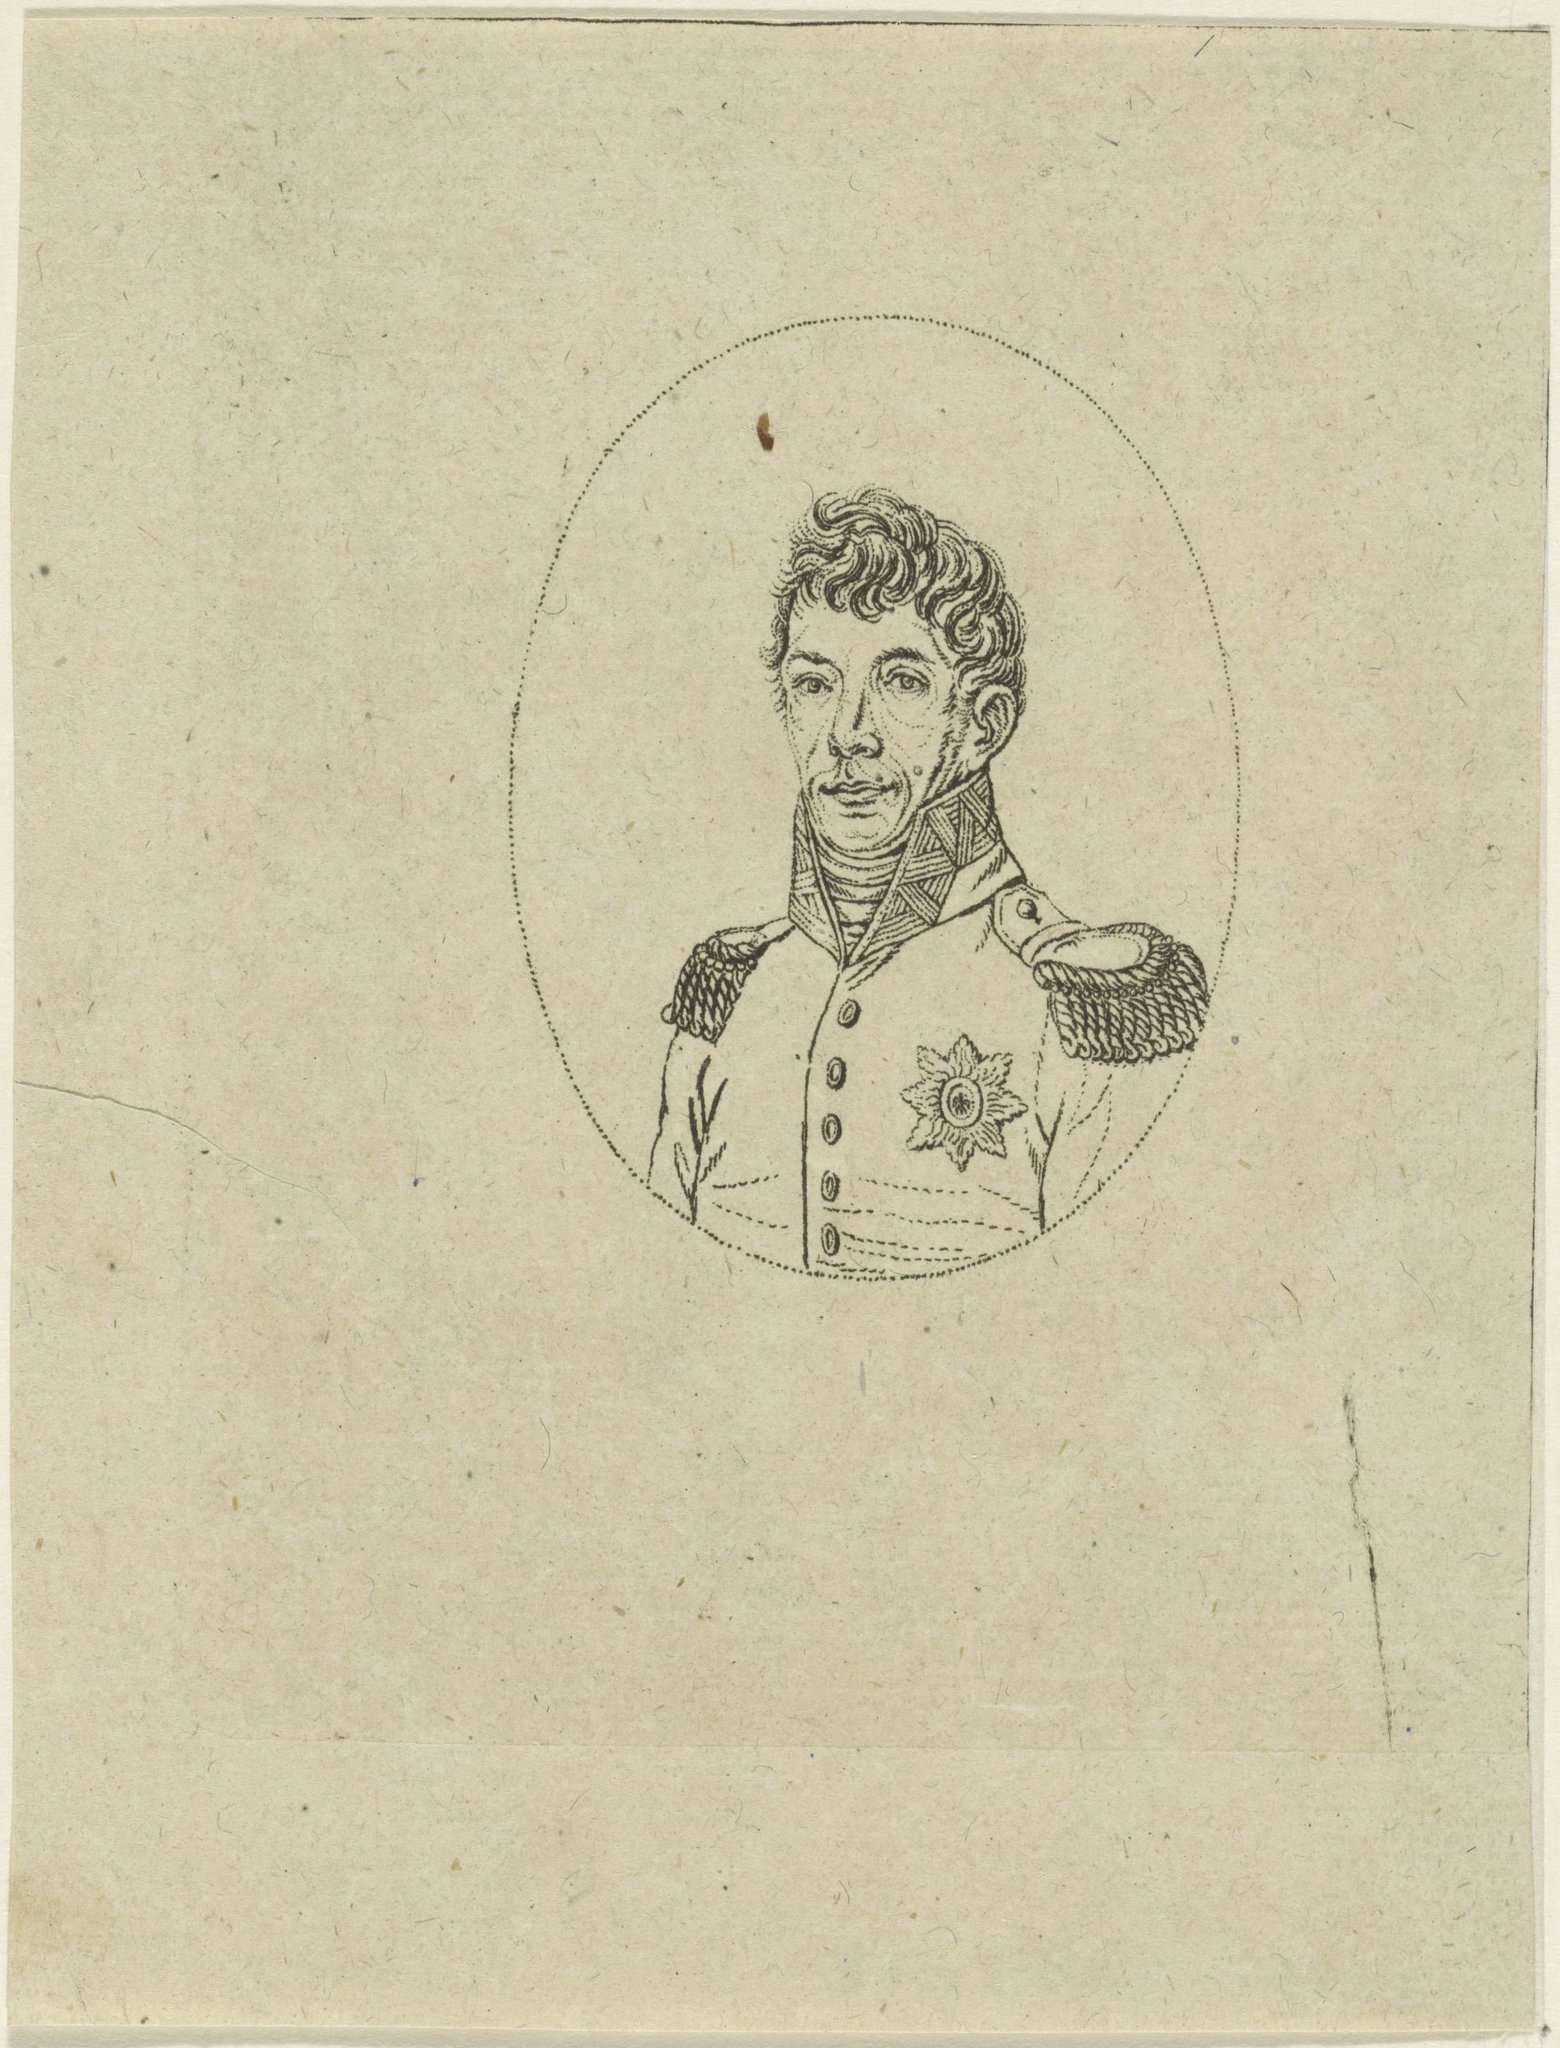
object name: print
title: Portret van Willem I Frederik, koning der Nederlanden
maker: Anonymous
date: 1790-1849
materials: paper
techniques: etching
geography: low countries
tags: the hague, berlin, william i of the netherlands, knighthood order (with name) - insignia of a knighthood order, e.g.: badge, chain (with name of order)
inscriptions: collector's mark: Lugt 2228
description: De hier vermelde titel verwijst naar de hoogst verkregen titel van de geportretteerde, niet per se naar de titel die de geportretteerde op deze voorstelling draagt.